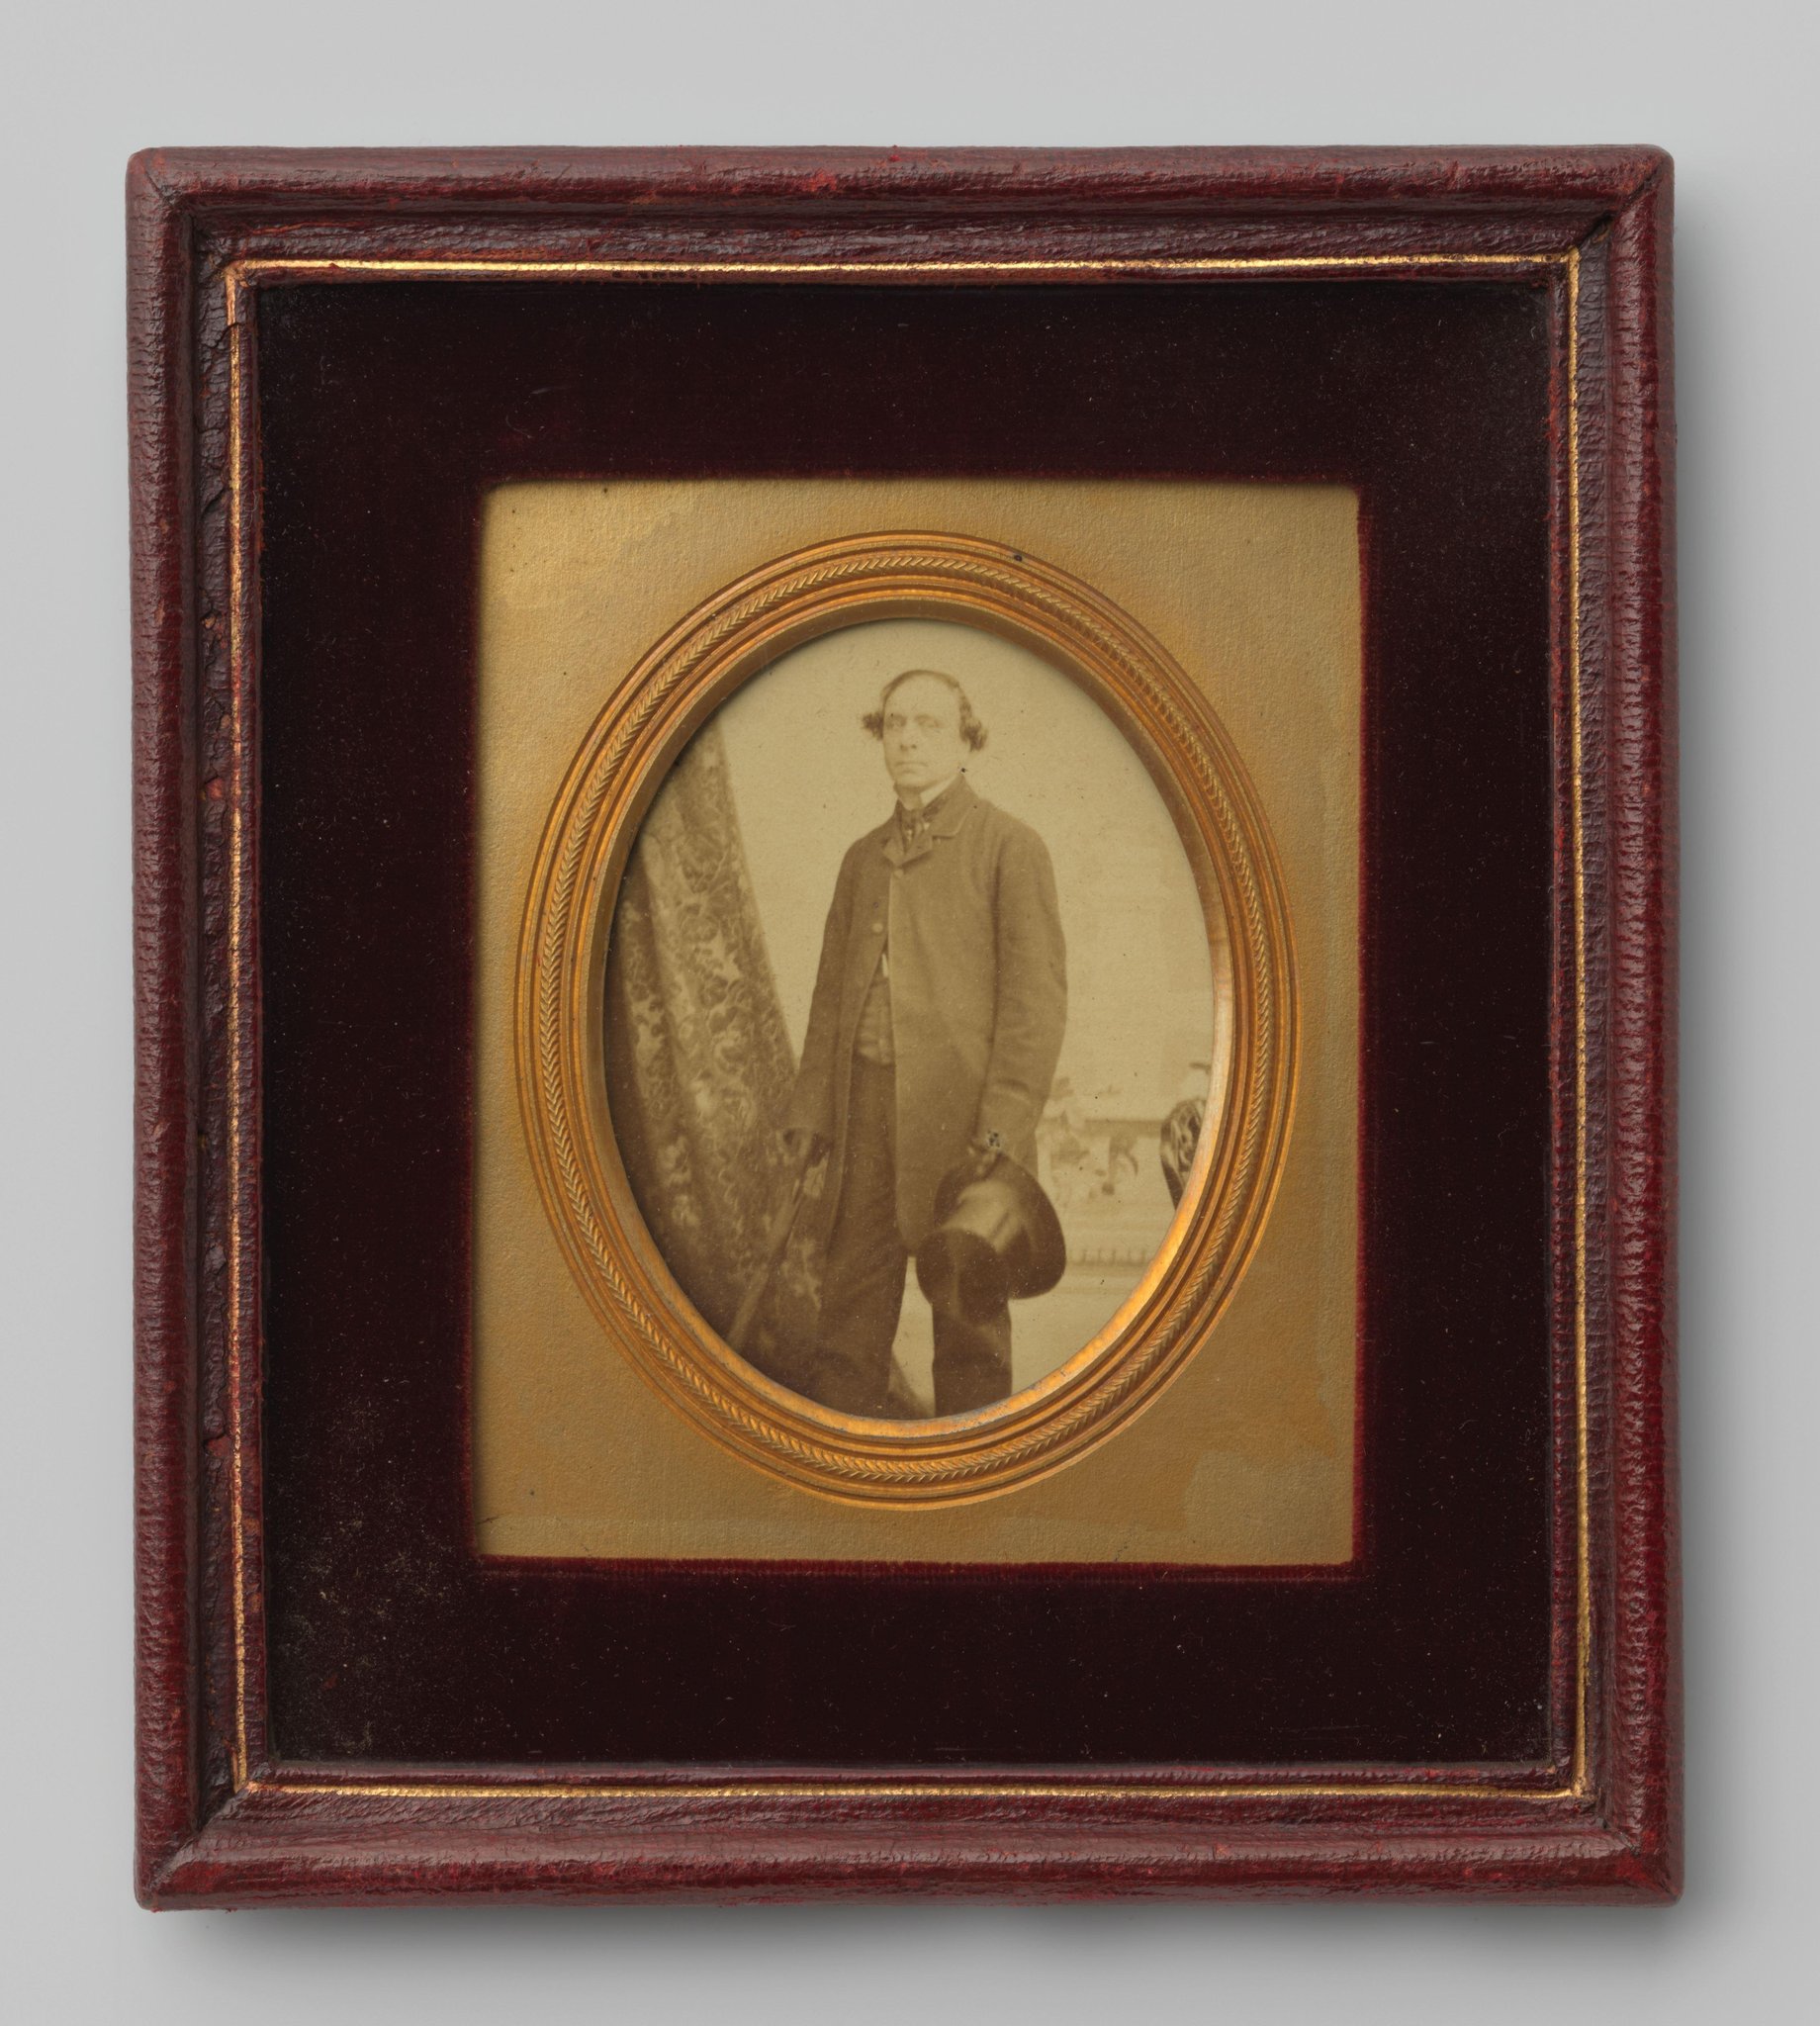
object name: photograph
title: Portret van een onbekende man met stok en hoge hoed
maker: Anonymous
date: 1880-1900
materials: cardboard, glass, leather, paper, velvet, wood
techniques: albumen print, gilding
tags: adult man, anonymous historical person portrayed